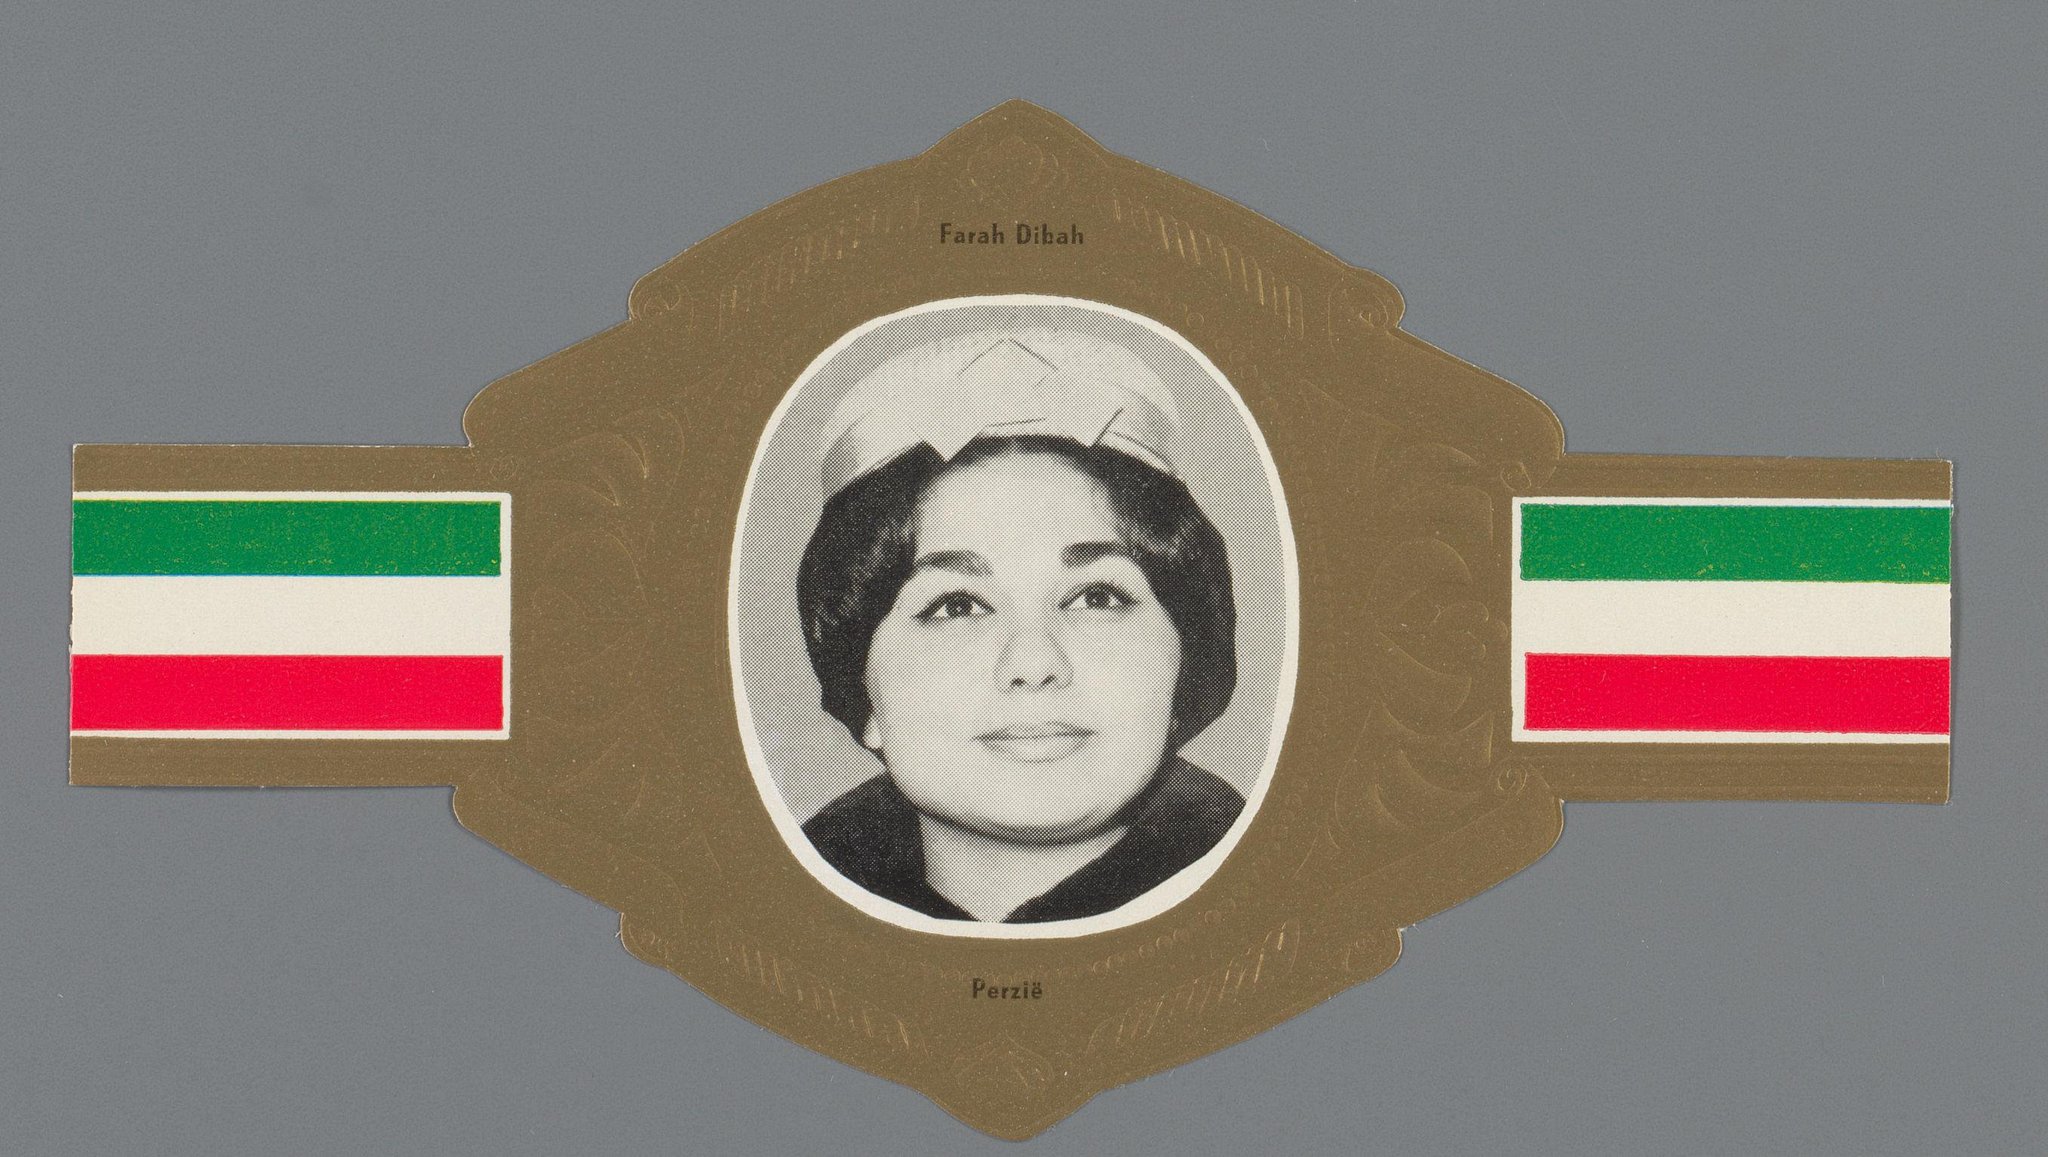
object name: photomechanical print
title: Portret van keizerin Farah Diba van Perzië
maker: Anonymous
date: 1961-1963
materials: paper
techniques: blind stamped, printing block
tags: historical persons - bb - woman, queen, empress, etc. (wife of a ruler)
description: Aan weerszijden van het portret is tweemaal de vlag van het land afgebeeld.